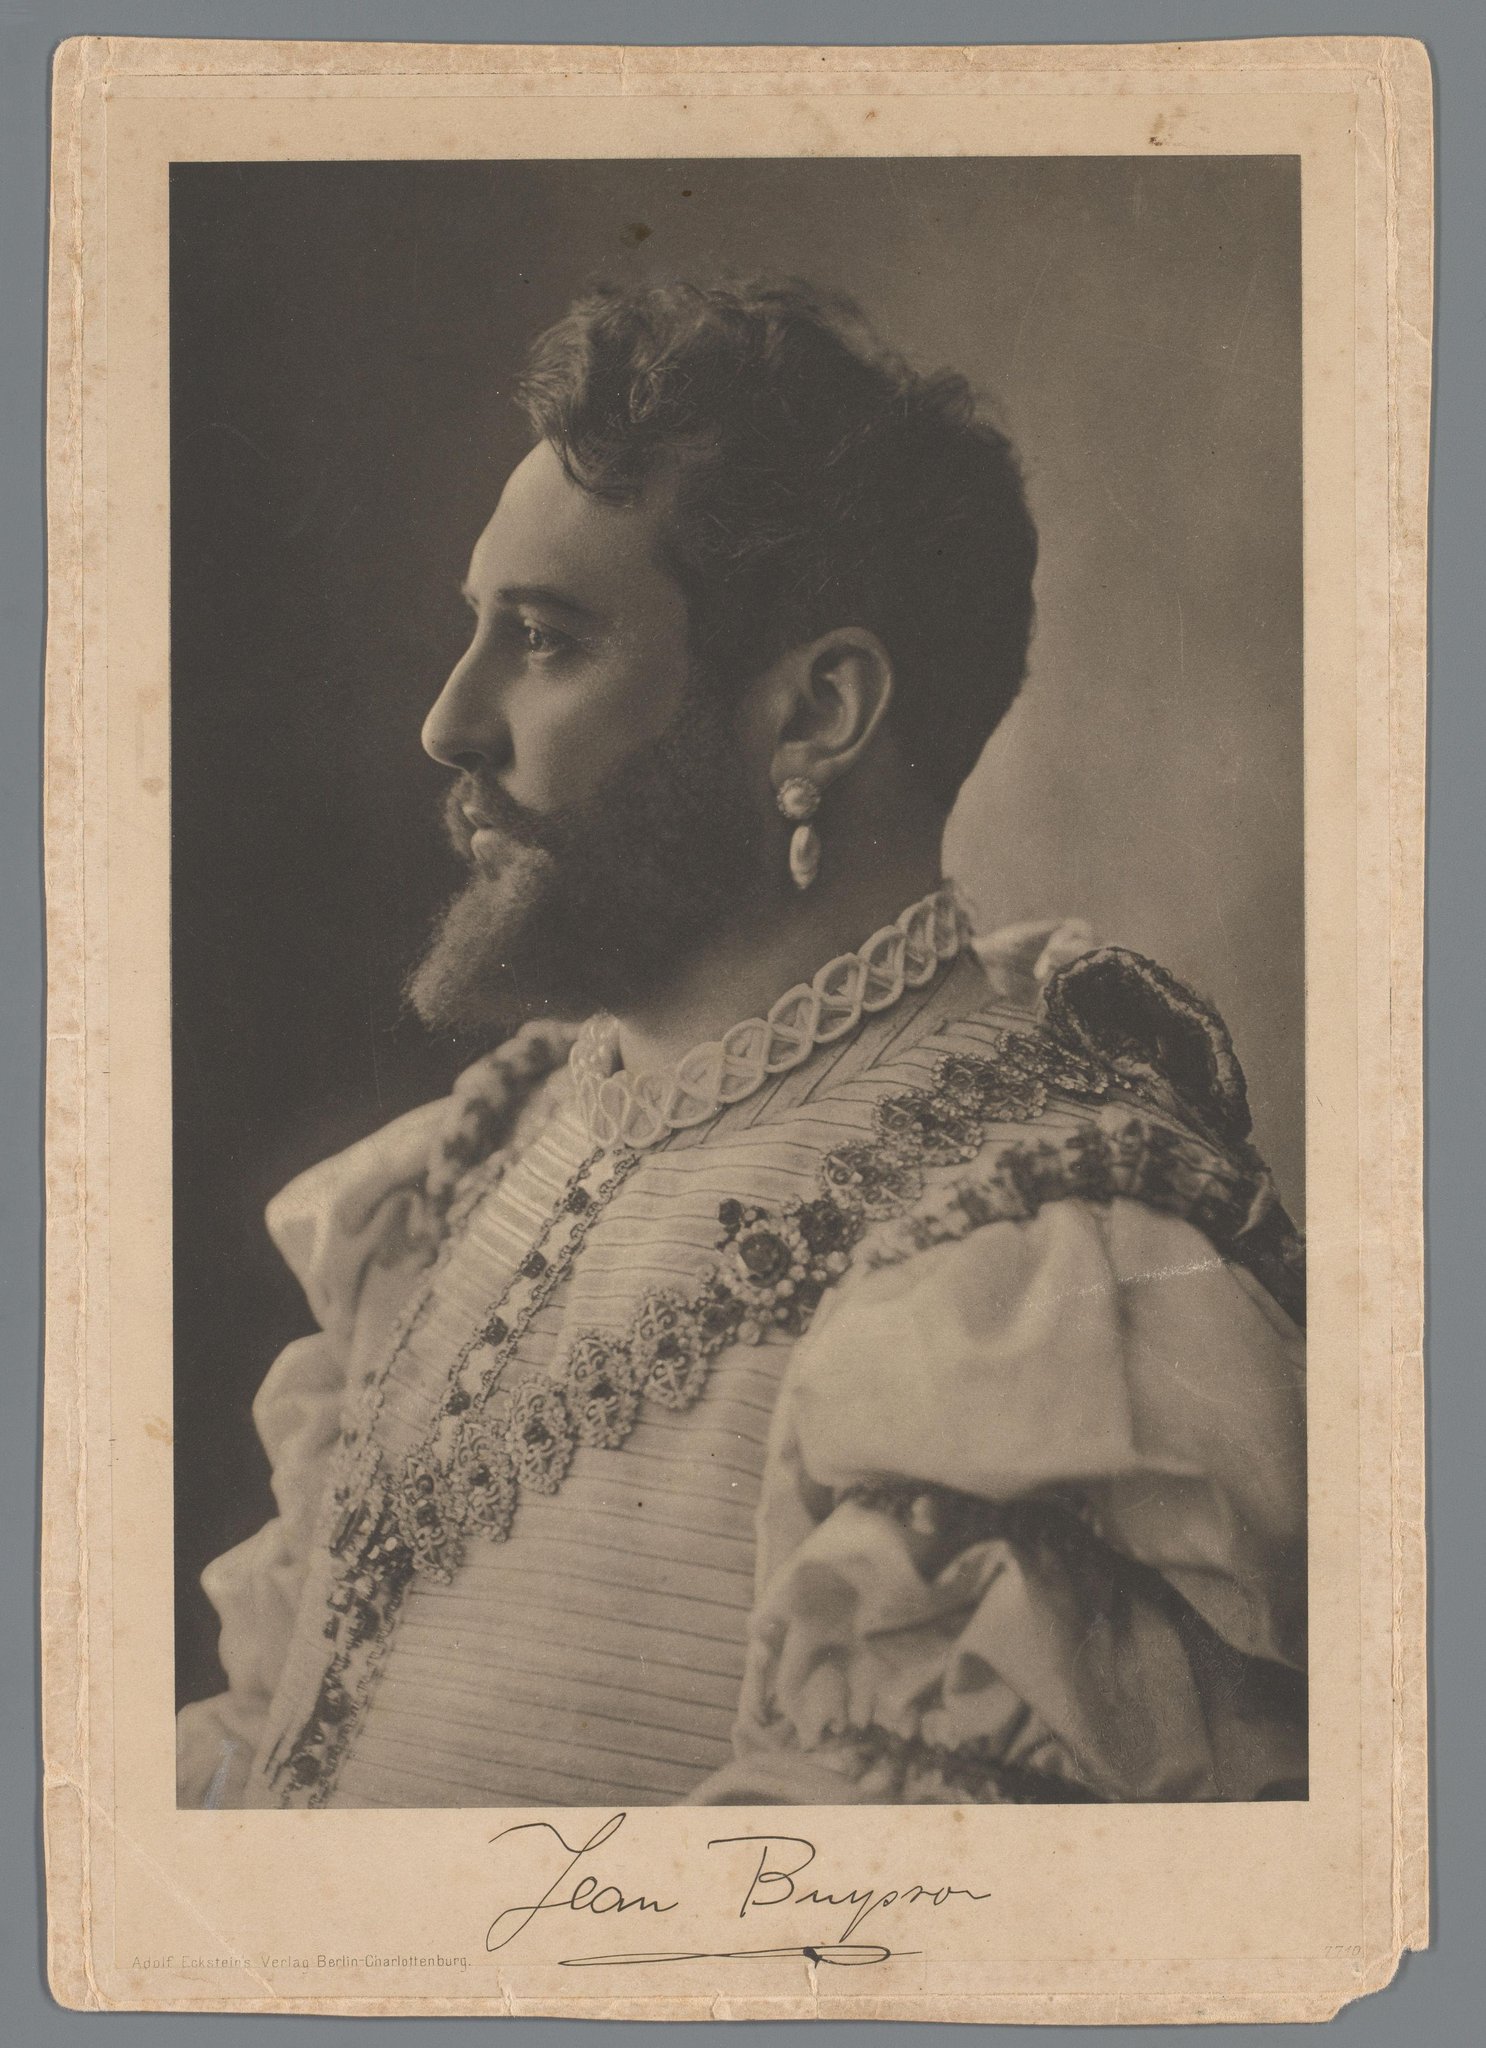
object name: photomechanical print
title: Portret van Jean Buysson als de hertog van Mantua in Rigoletto, mogelijk in Londen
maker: Anonymous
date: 1913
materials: cardboard, paper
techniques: photoaquatint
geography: london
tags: amsterdam, paris, historical persons (portraits and scenes from the life)